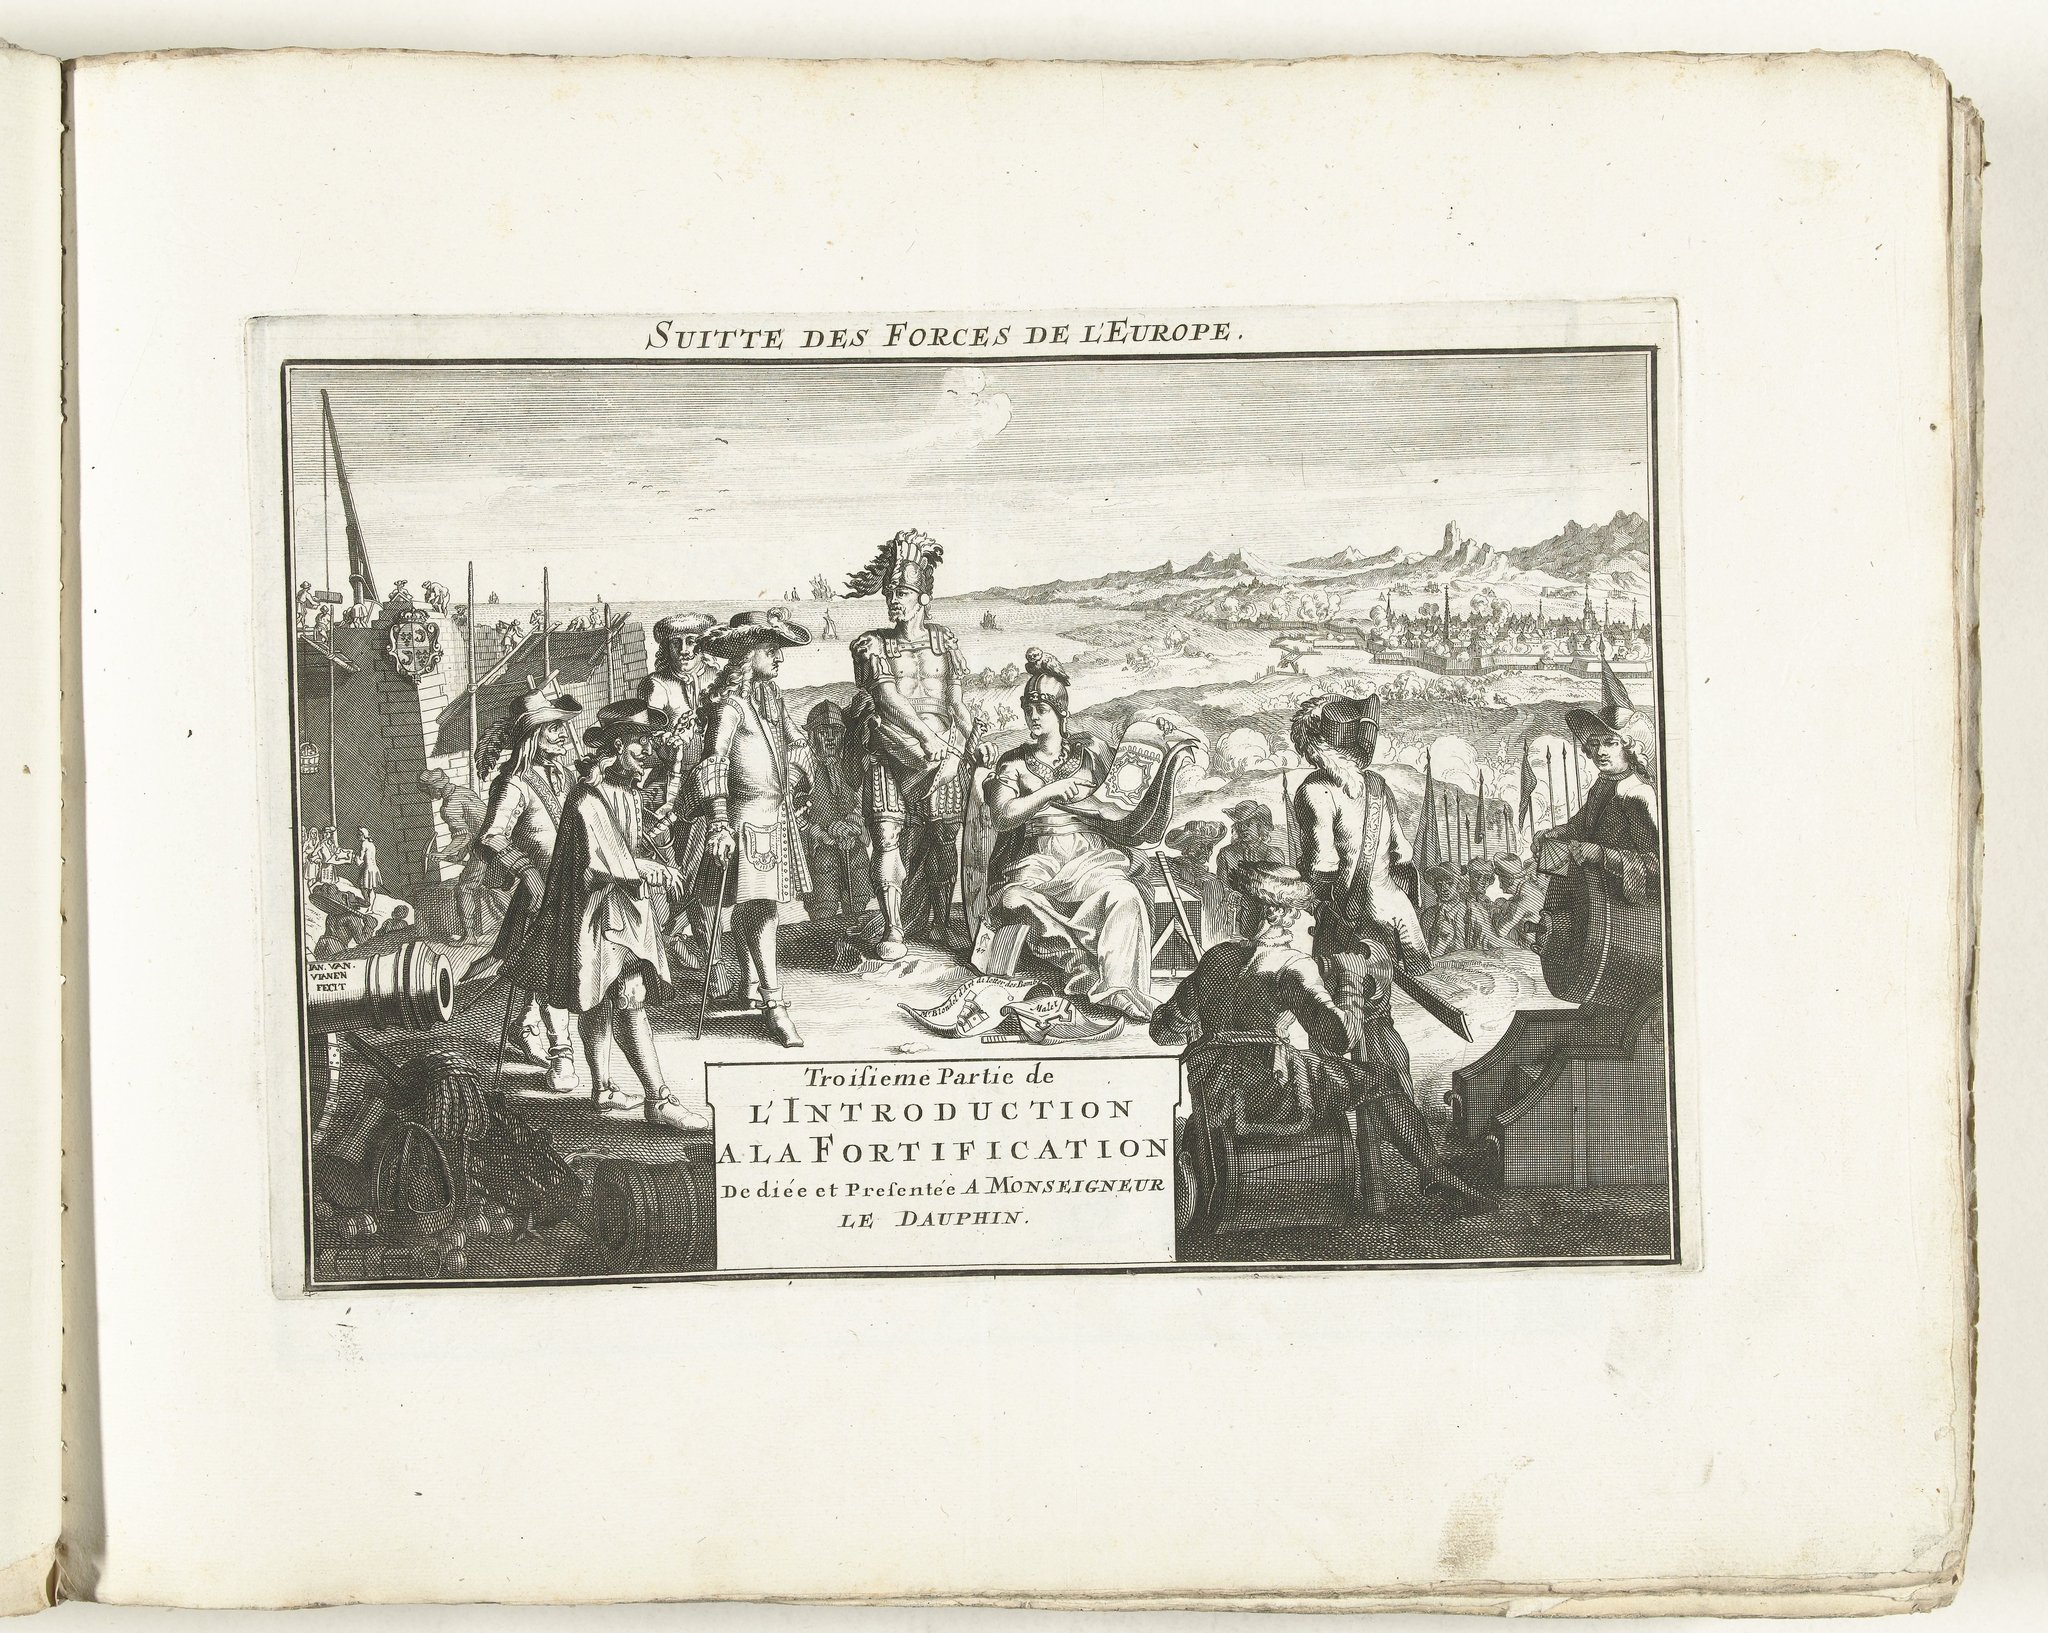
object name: titelprent, frontispice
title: Titelprent voor prentwerk: Les Forces de l'Europe, Asie, Afrique et Amerique (deel 3), ca. 1702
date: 1702-1703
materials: paper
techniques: etching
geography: amsterdam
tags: fortifications, military engineering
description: Titelprent met Franse legeraanvoerders en ingenieurs met Minerva en Mars. Titelprent voor het derde deel van het prentwerk: Les Forces de l'Europe, Asie, Afrique et Amerique, uitgegeven ca. 1702. Ongenummerd [53]. Het prentwerk bestaat in totaal uit 276 genummerde platen van vermaarde sterke steden en vestingen in het kader van de Spaanse Successieoorlog. Voor het merendeel zijn deze platen gekopieerd naar de anonieme Franse platen: in Les forces de l'Europe en in: Le theatre de la guerre, dans les Pays-Bas, beide oorspronkelijk uitgegeven door Nicolas de Fer te Parijs (1693-1697) in het kader van de Negenjarige Oorlog. Titel in het Frans.